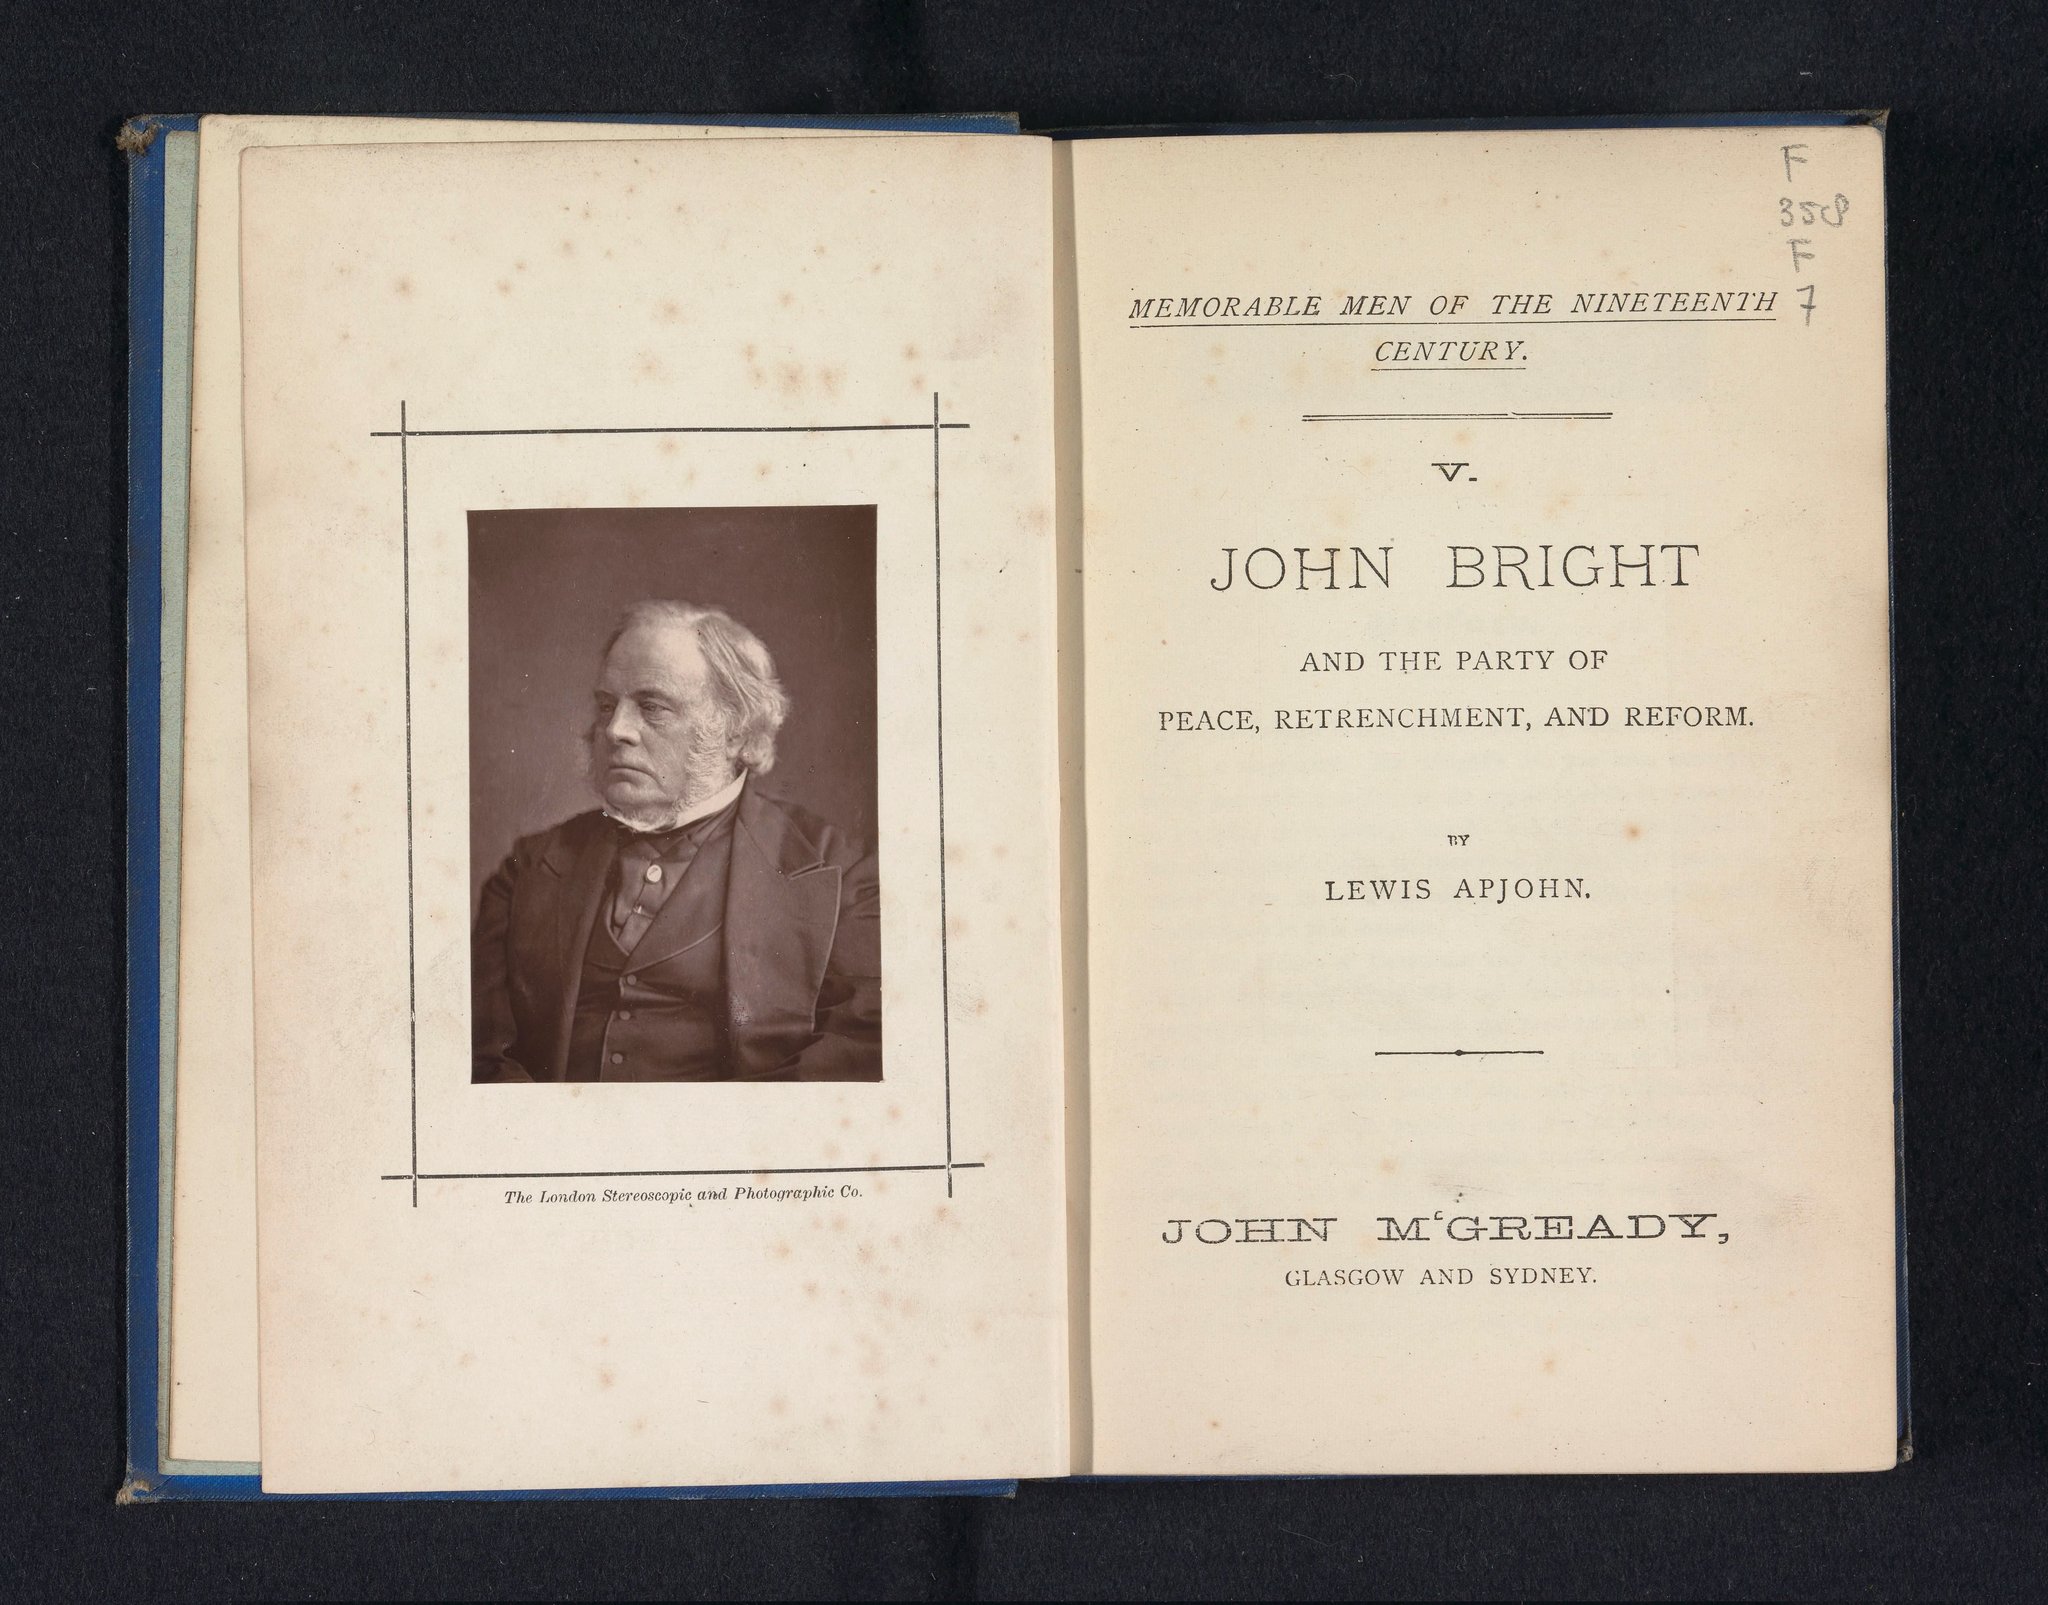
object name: book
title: John Bright and the party of peace, retrechment, and reform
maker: john mcgready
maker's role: publisher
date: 1889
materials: cardboard, linen, paper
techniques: woodburytype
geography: sydney